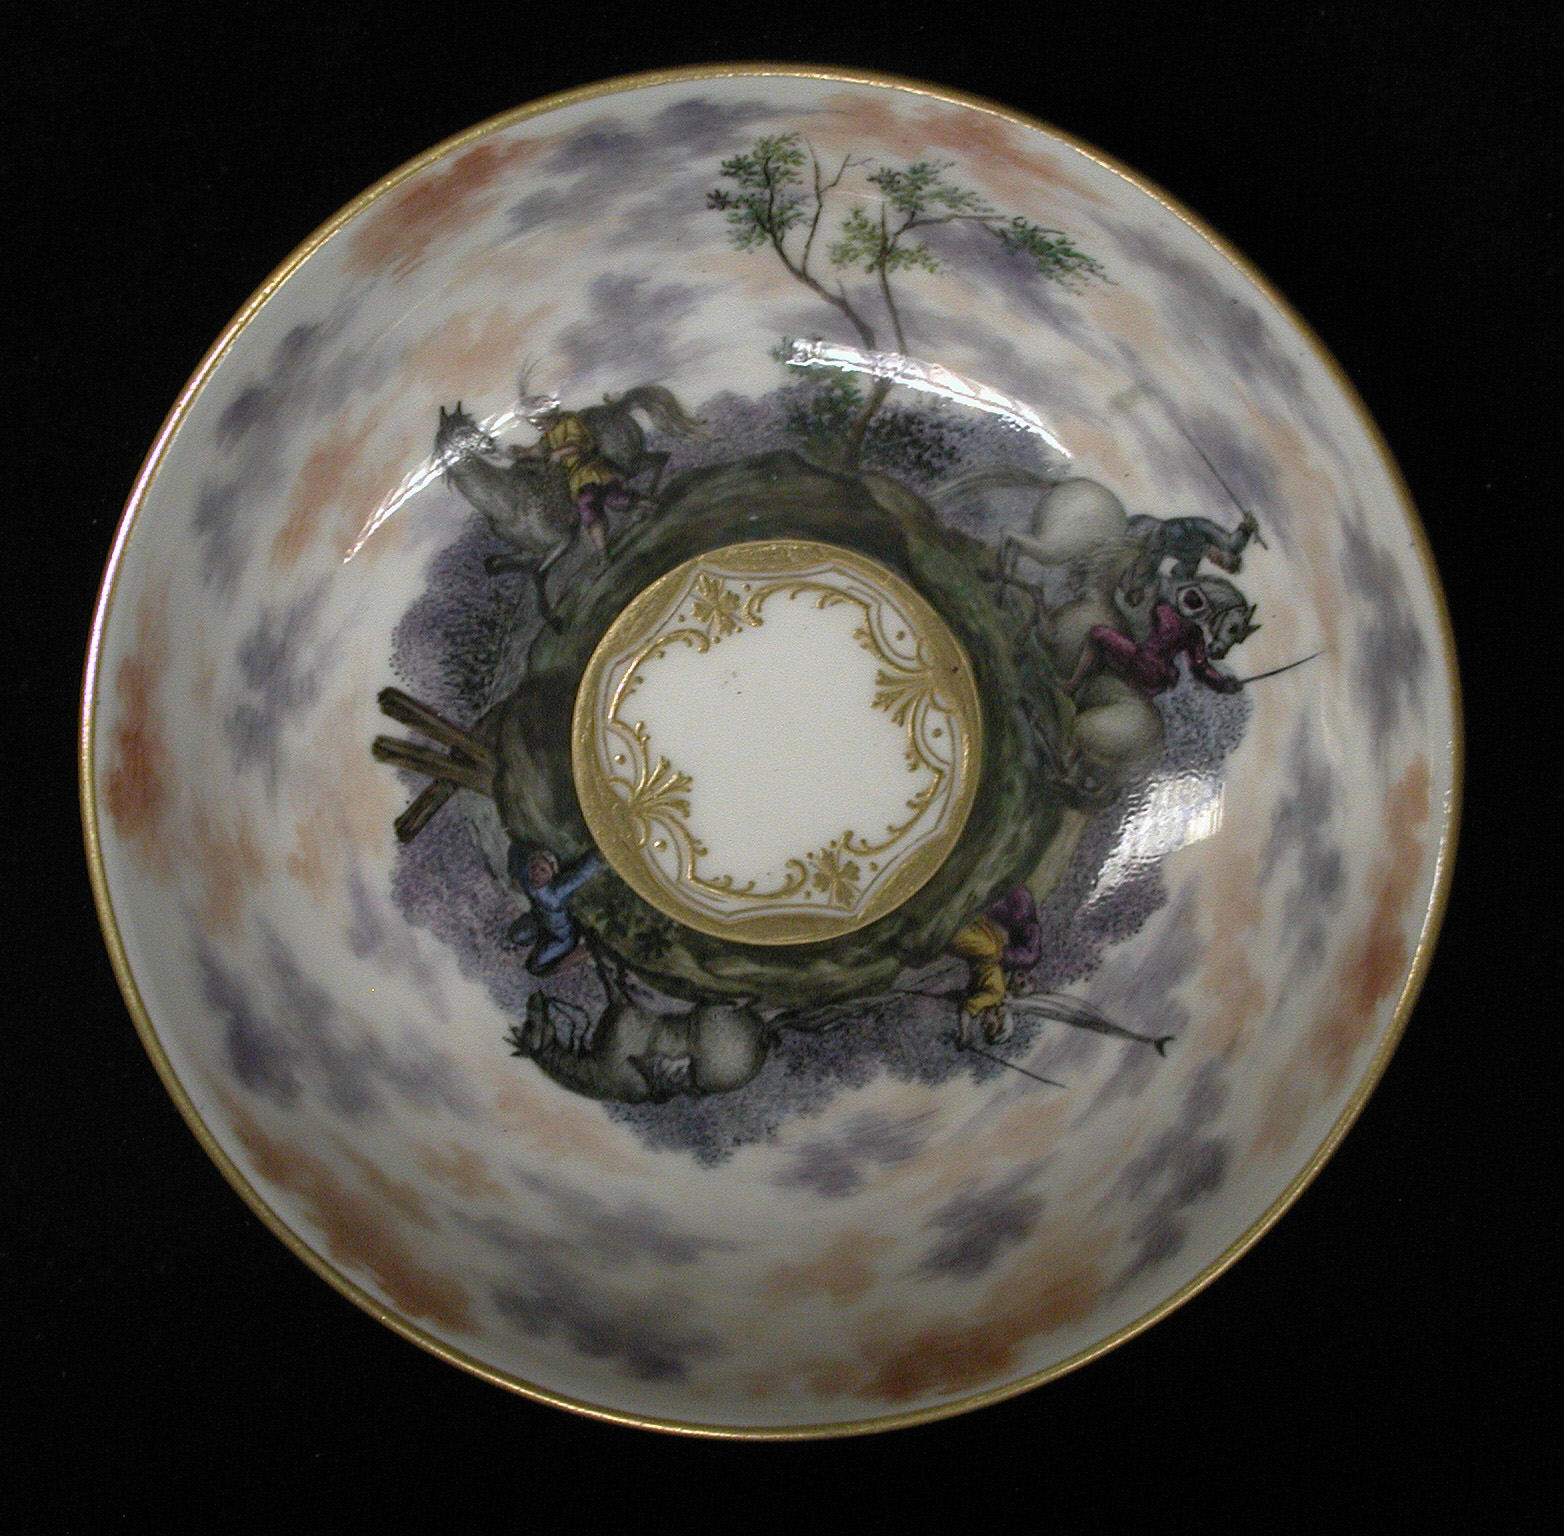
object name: saucer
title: Saucer (part of a service)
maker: capodimonte porcelain manufactory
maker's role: manufactory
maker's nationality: italian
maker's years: 1740-1759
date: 1743-1759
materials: soft paste porcelain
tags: men,horses